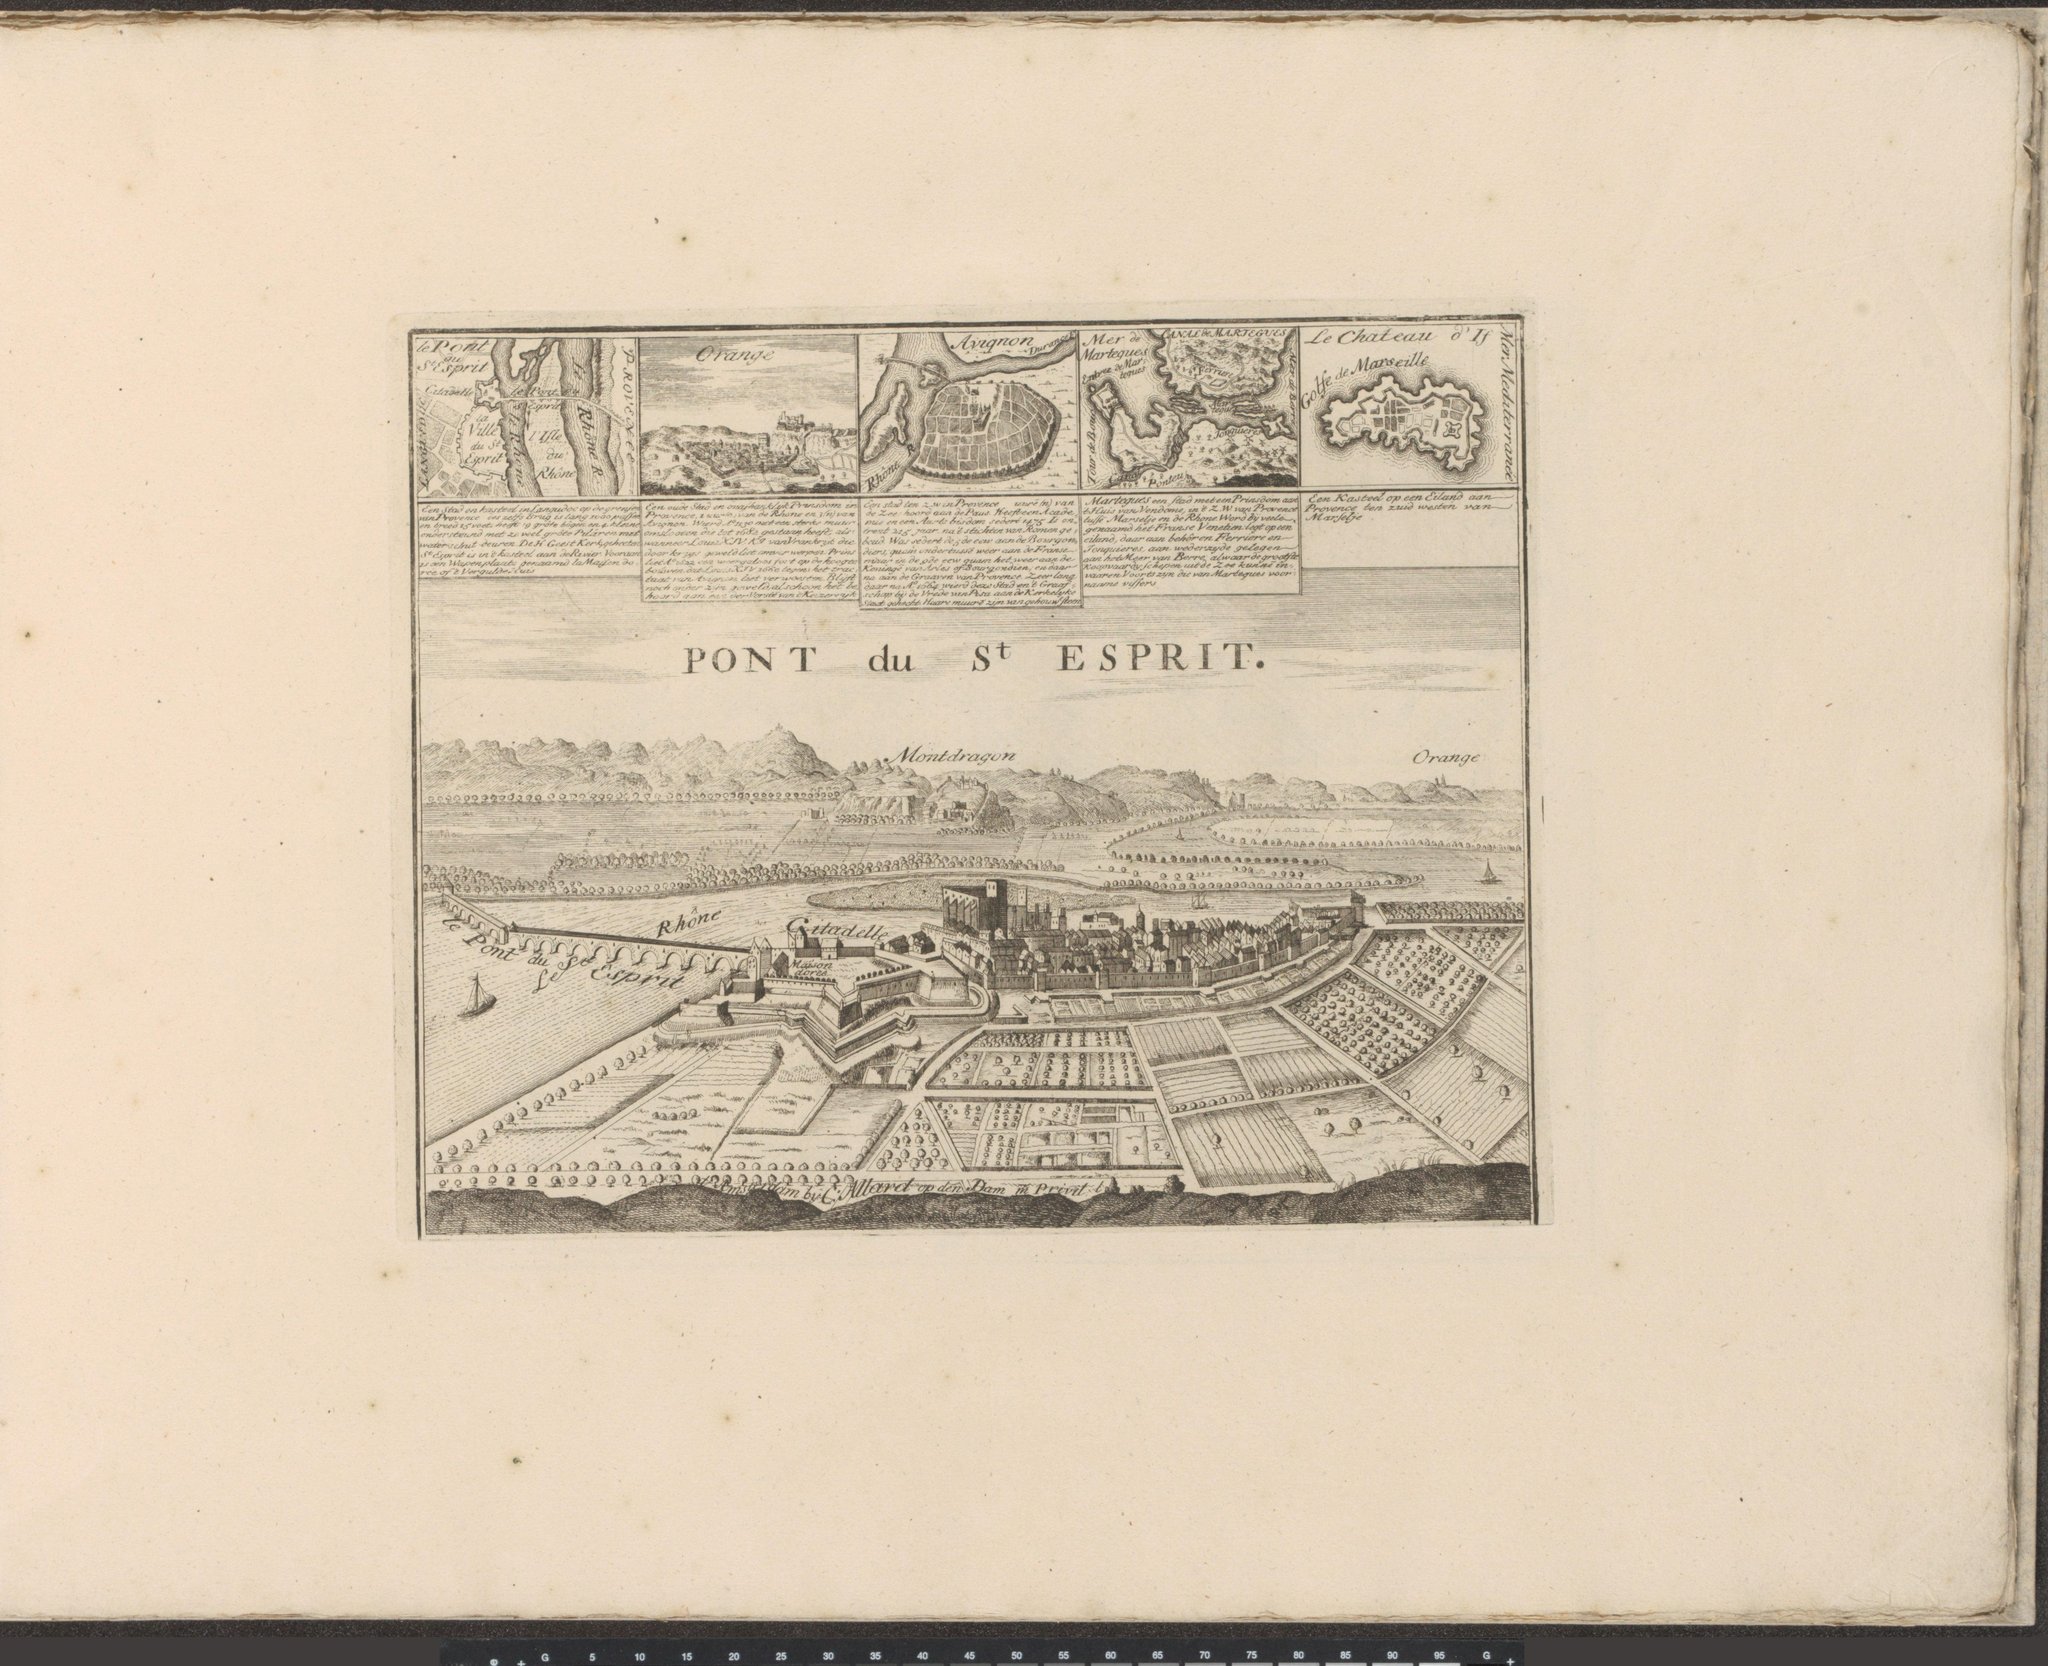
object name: print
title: Pont du St. Esprit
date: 1701-1733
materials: paper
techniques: etching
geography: leiden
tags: fortifications, military engineering, maps of cities, marseille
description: Gezicht op Pont-Saint-Esprit met de brug over de Rhône. Vijf inzetten met andere plaatsen in Frankrijk. Teksten in het Nederlands en Frans. De prent maakt deel uit van een album.